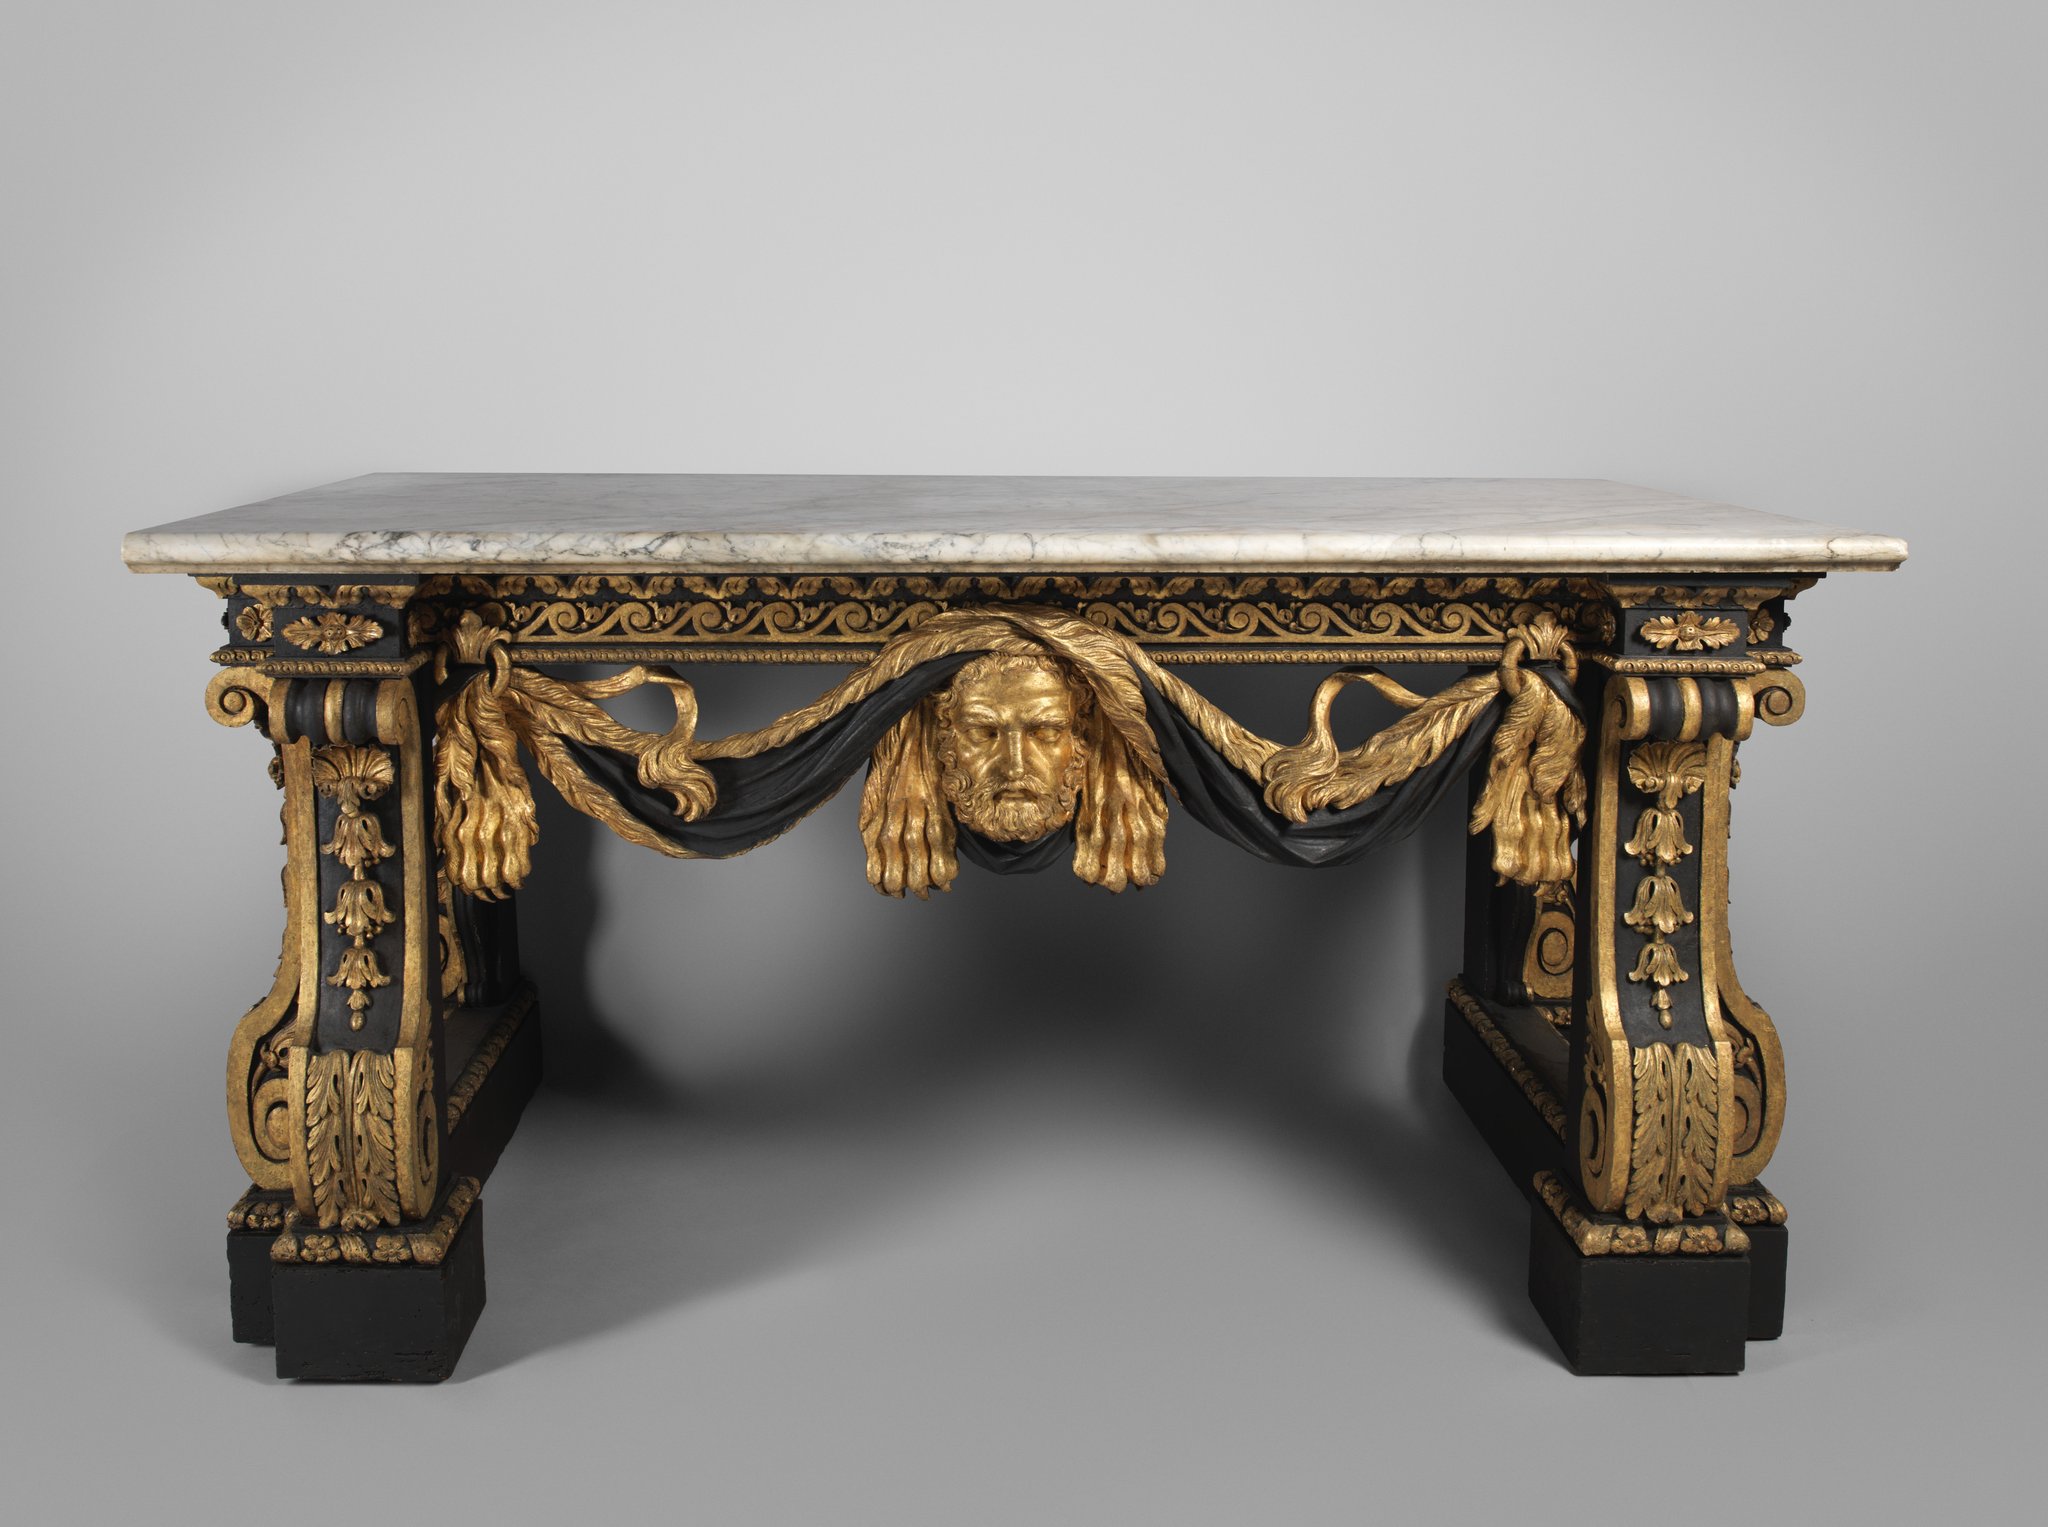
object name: table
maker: matthias lock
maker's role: maker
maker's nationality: british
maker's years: 1705-1760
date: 1740-1745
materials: marble, wood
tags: hercules